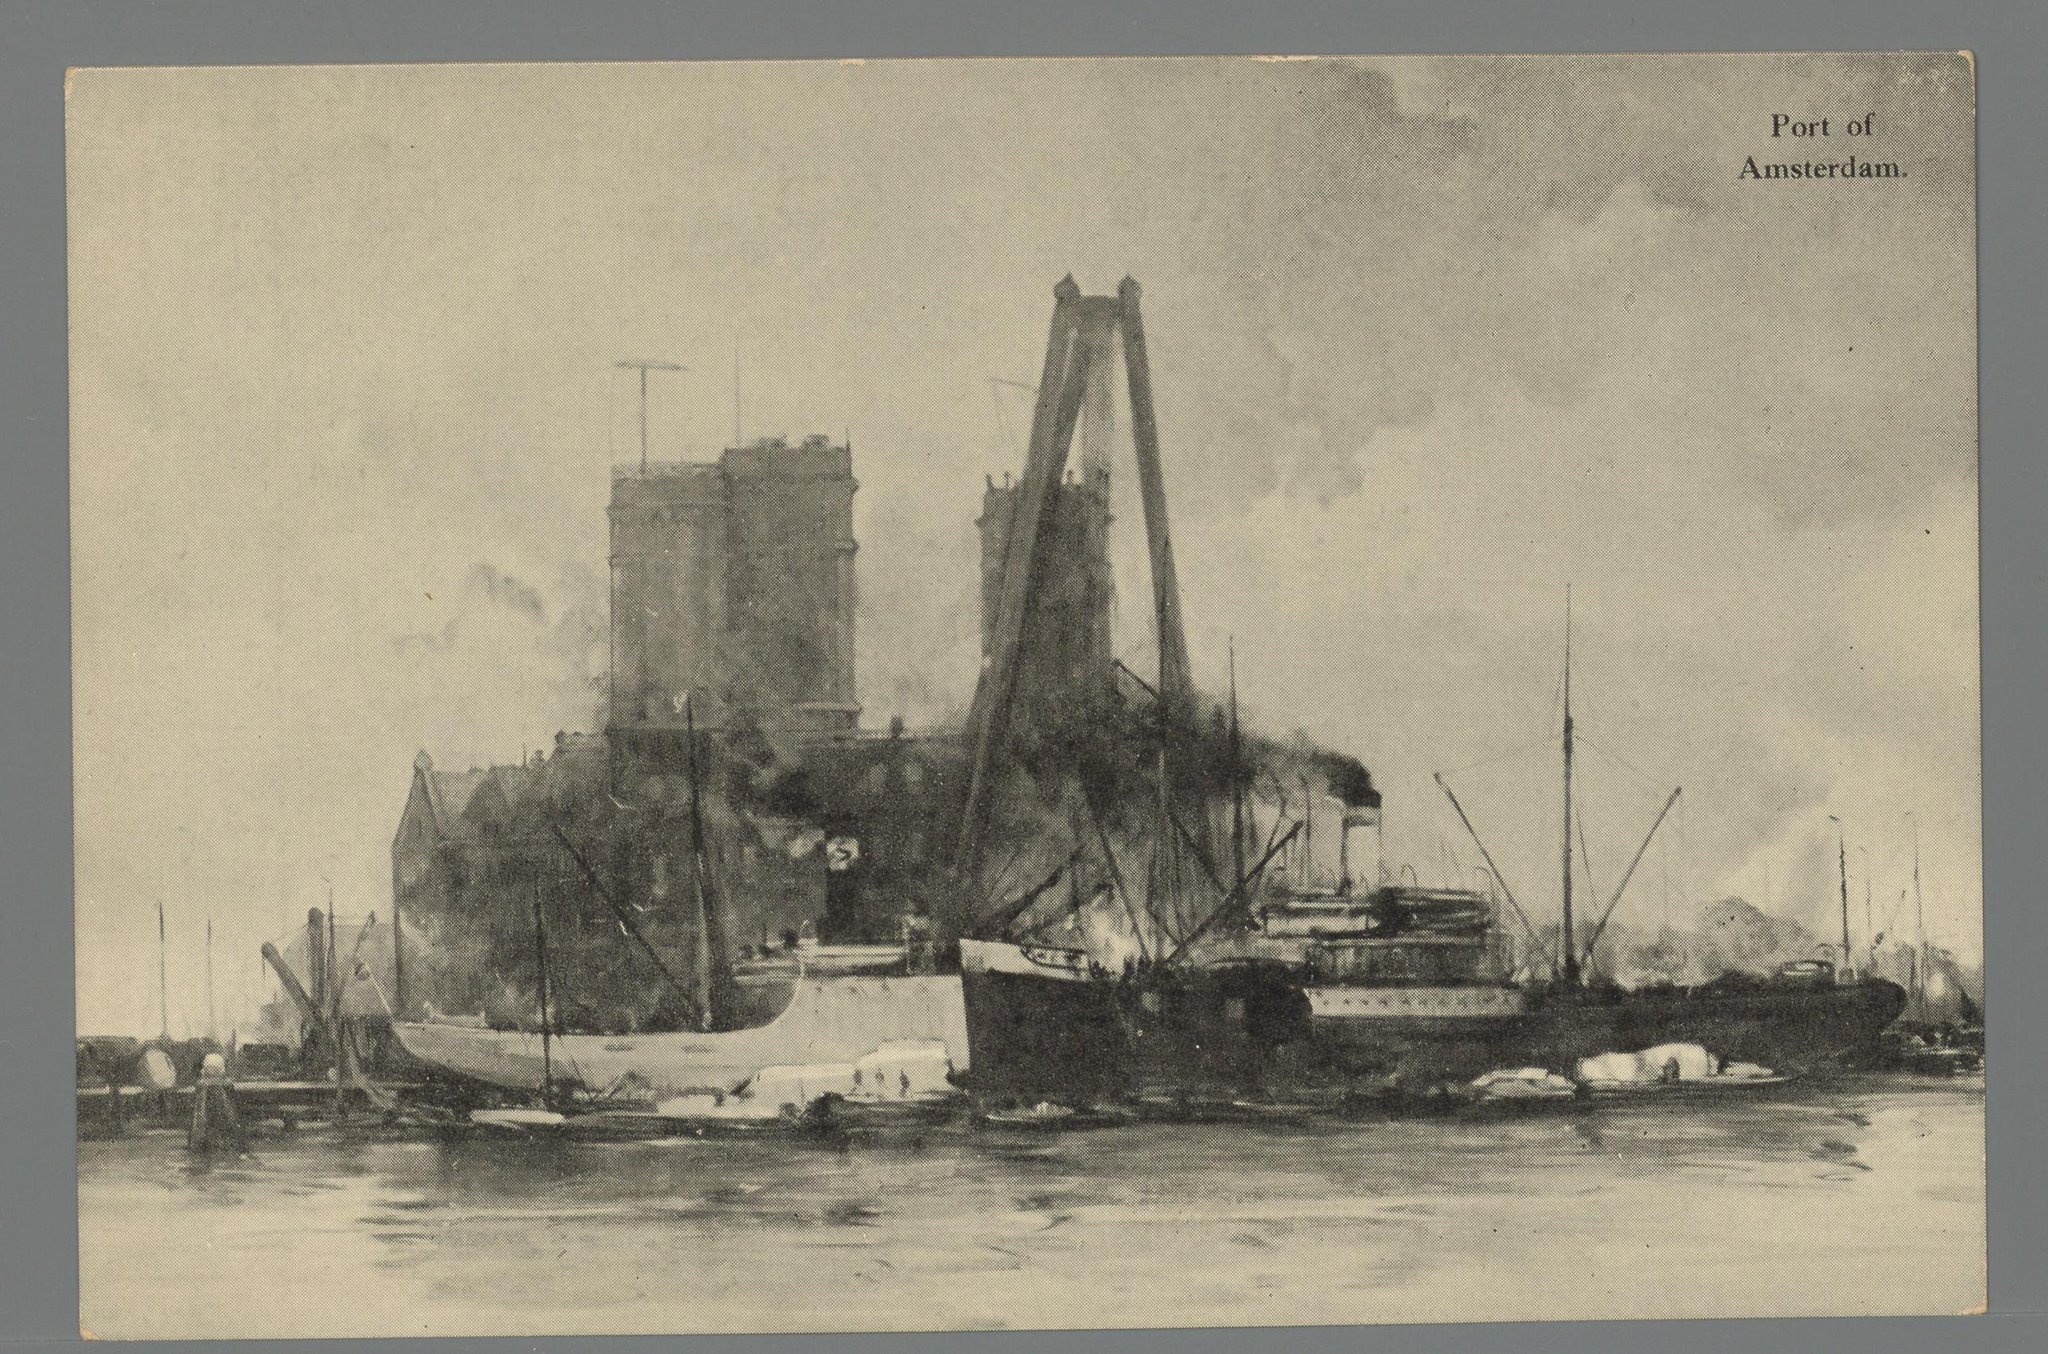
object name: photomechanical print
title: Reproductie van: Port of Amsterdam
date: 1912-1930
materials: cardboard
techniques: autotype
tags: harbour, steamship, motorship, port of amsterdam